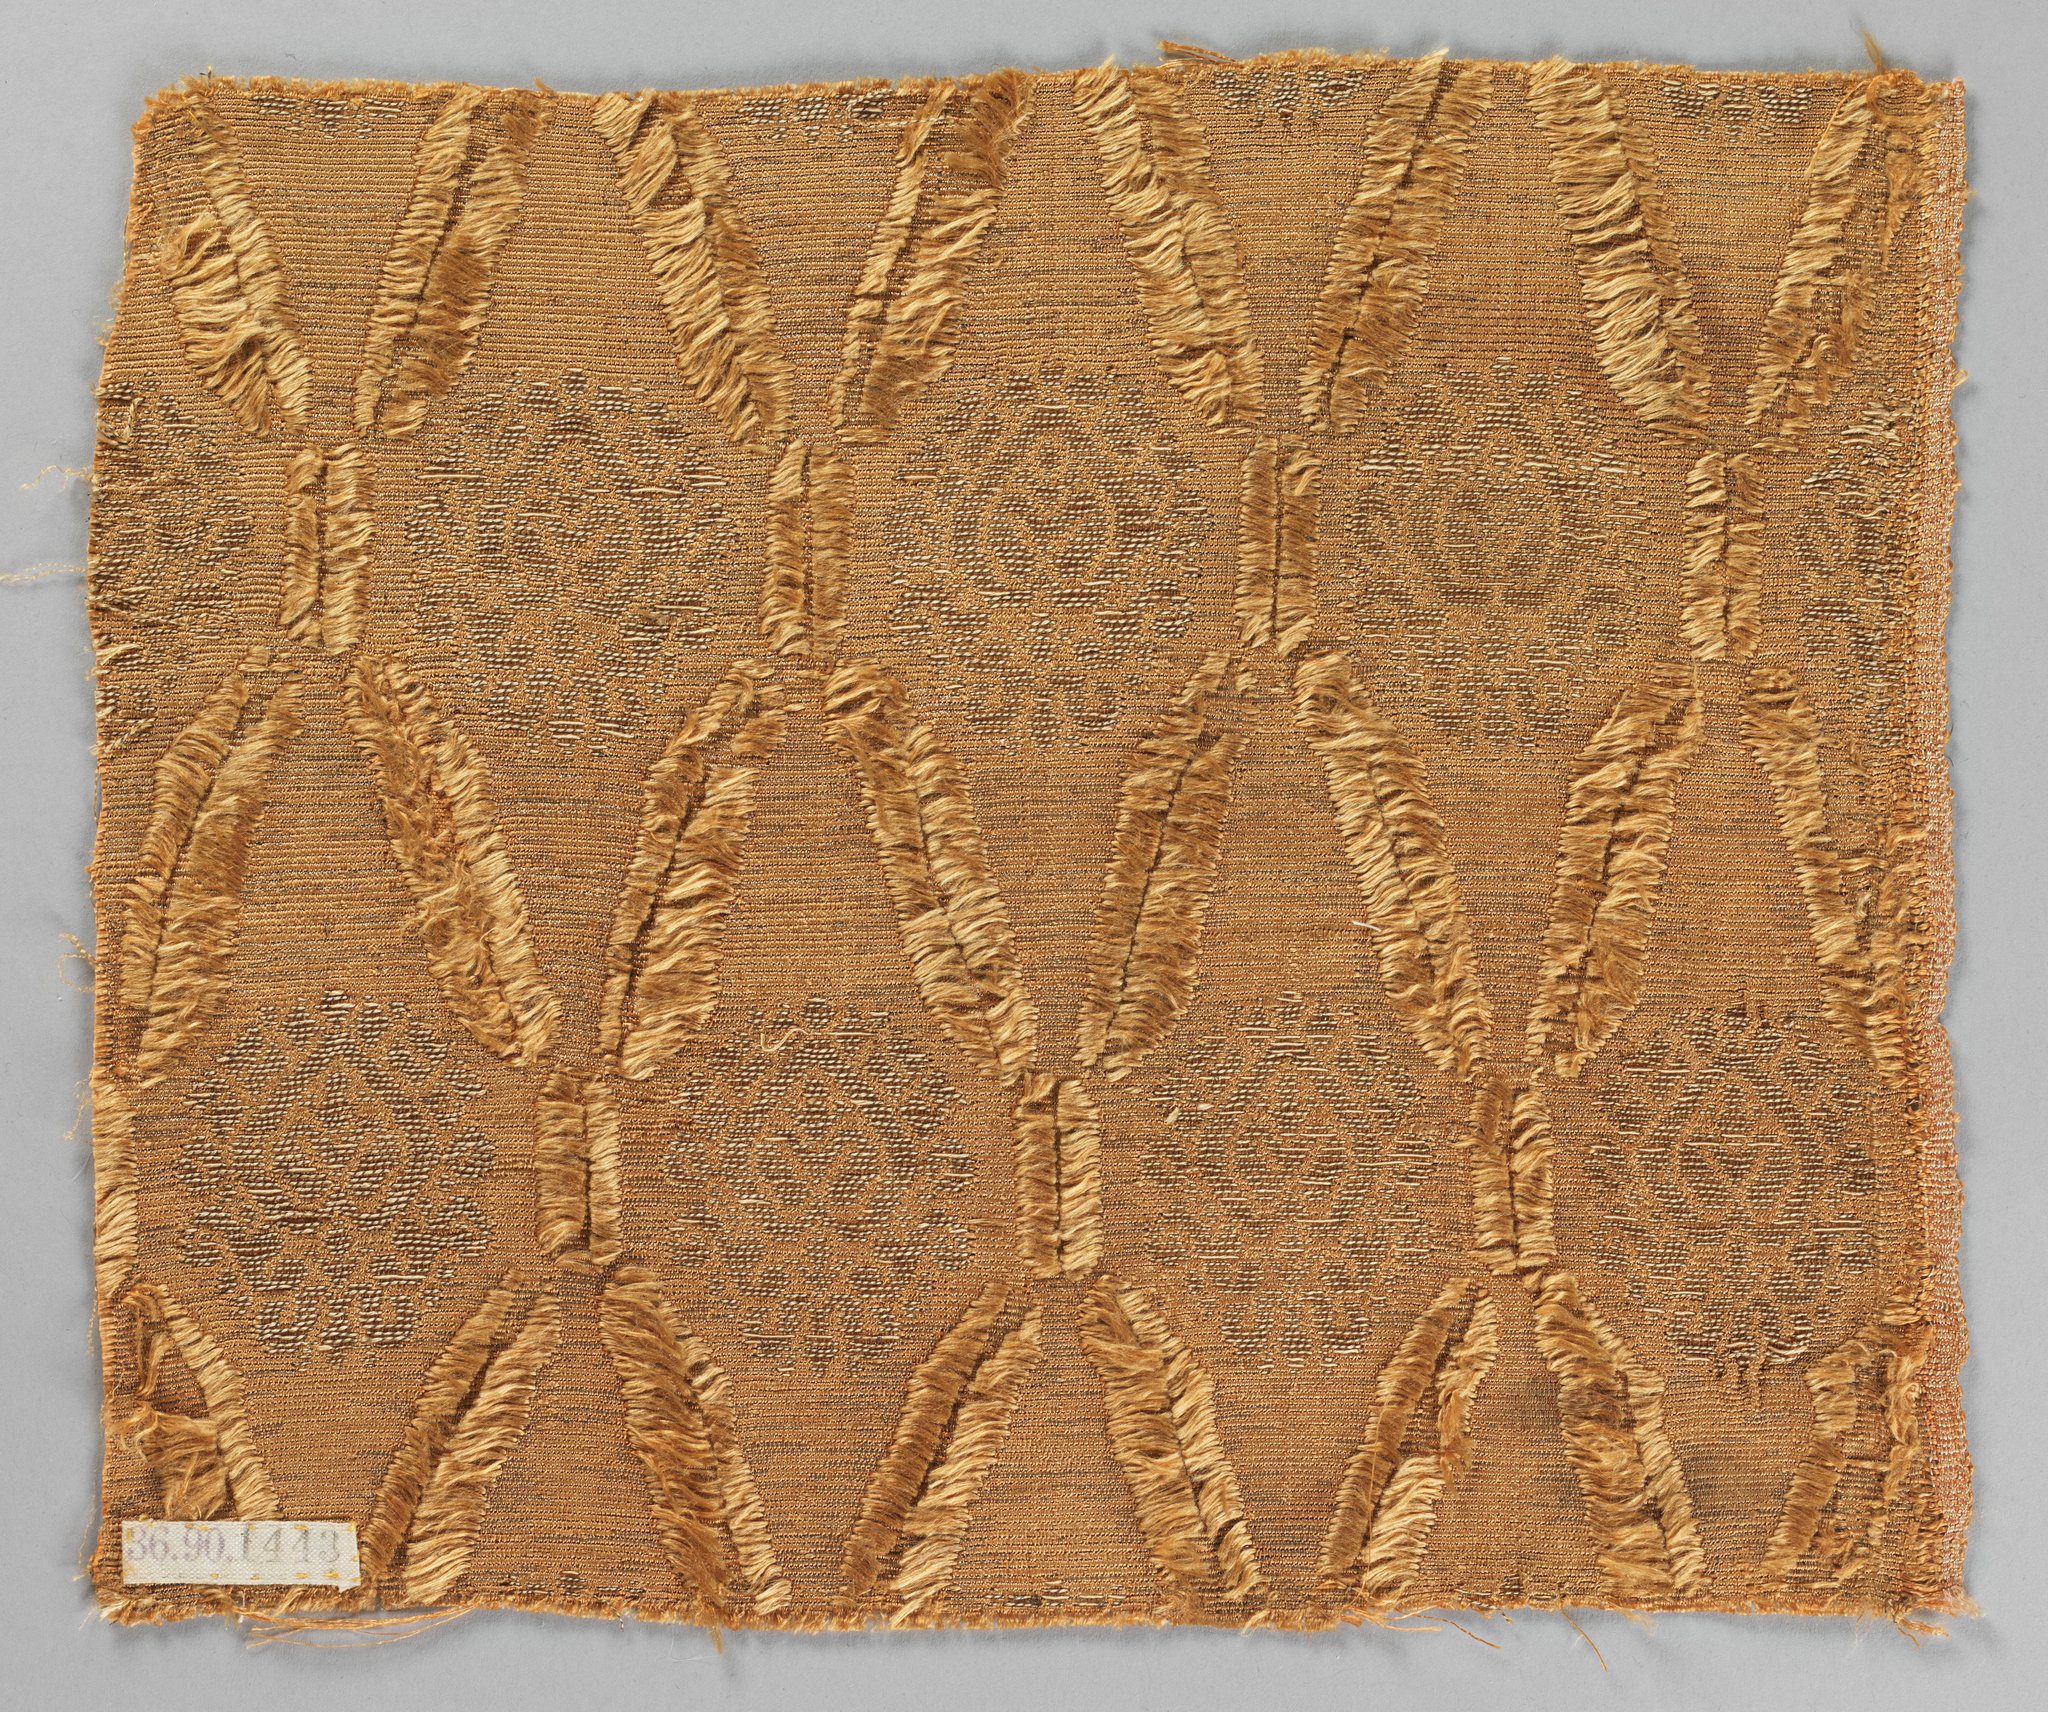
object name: fragment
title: Fragment of brocaded silk with imitation slashing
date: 1601-1700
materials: metal thread, silk